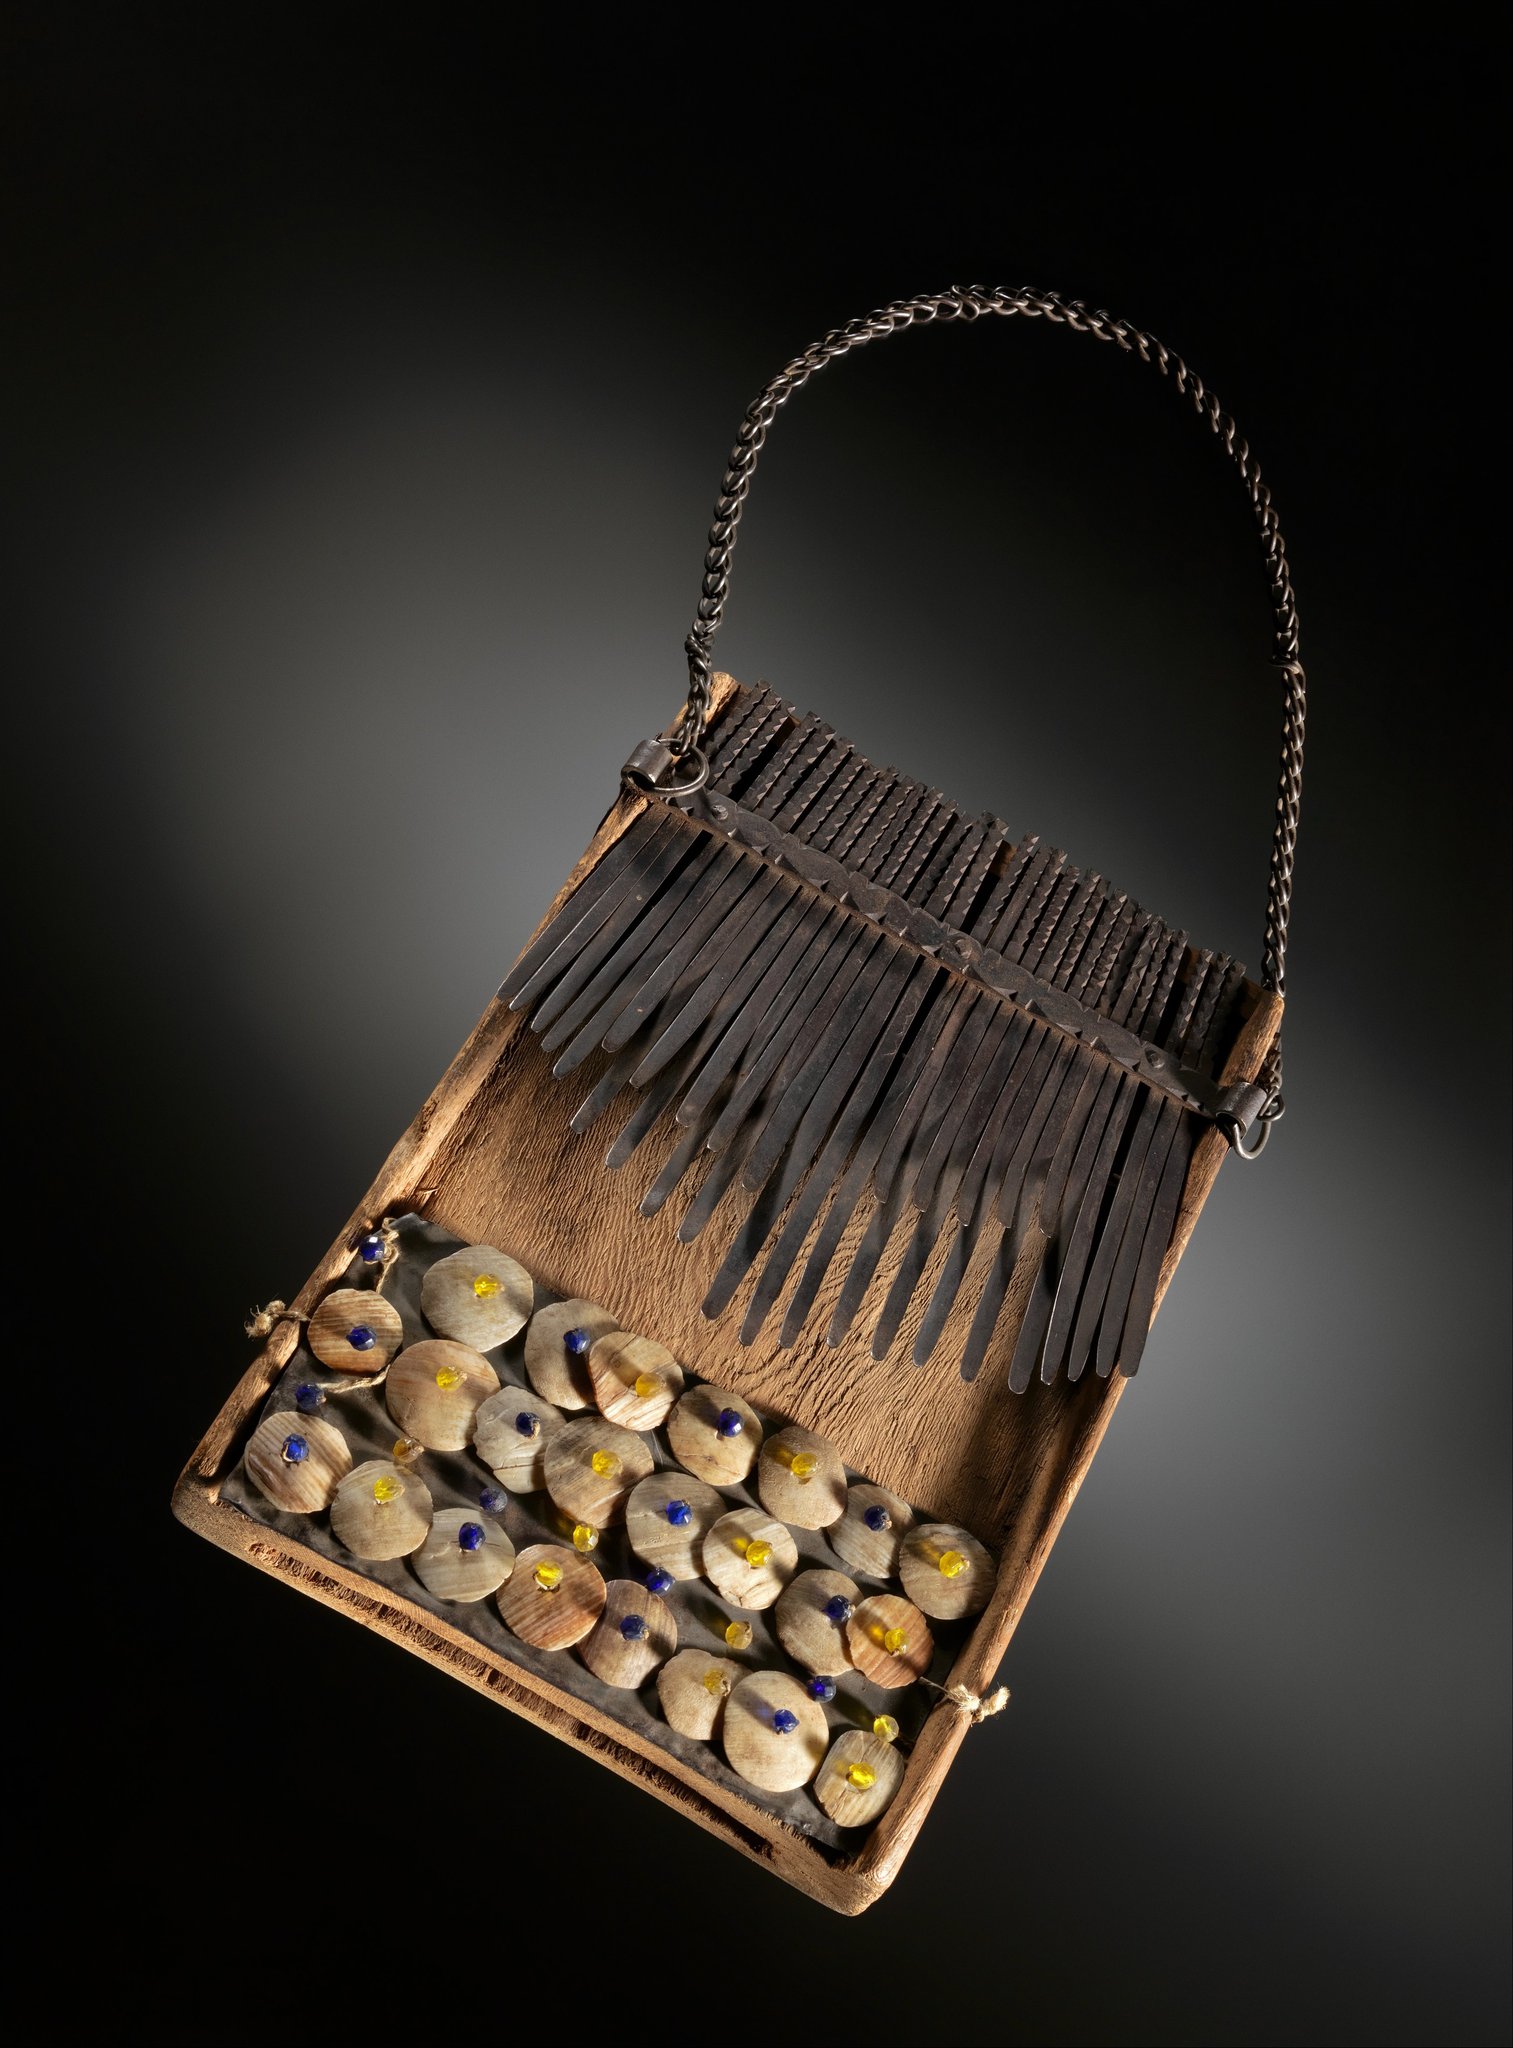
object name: nyonganyonga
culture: barwe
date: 1900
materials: metal, shell, wood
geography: mozambique